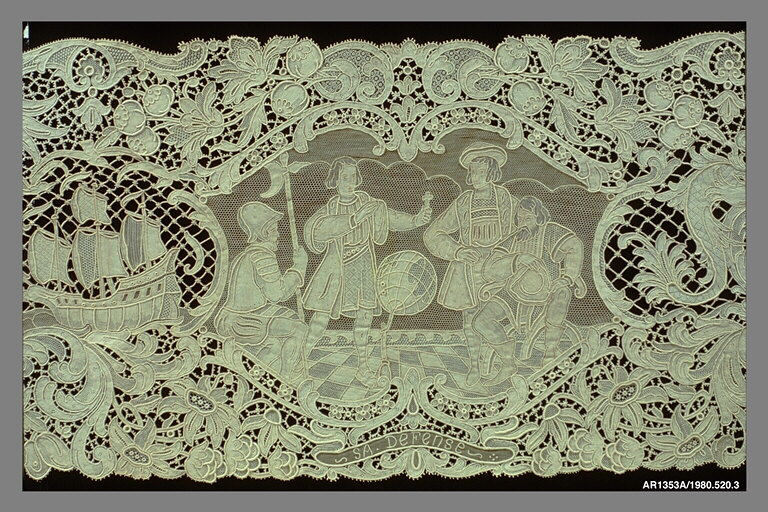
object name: runner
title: Runner (from a set of table linens)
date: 1867-1900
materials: linen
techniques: lace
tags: men,flowers,ships